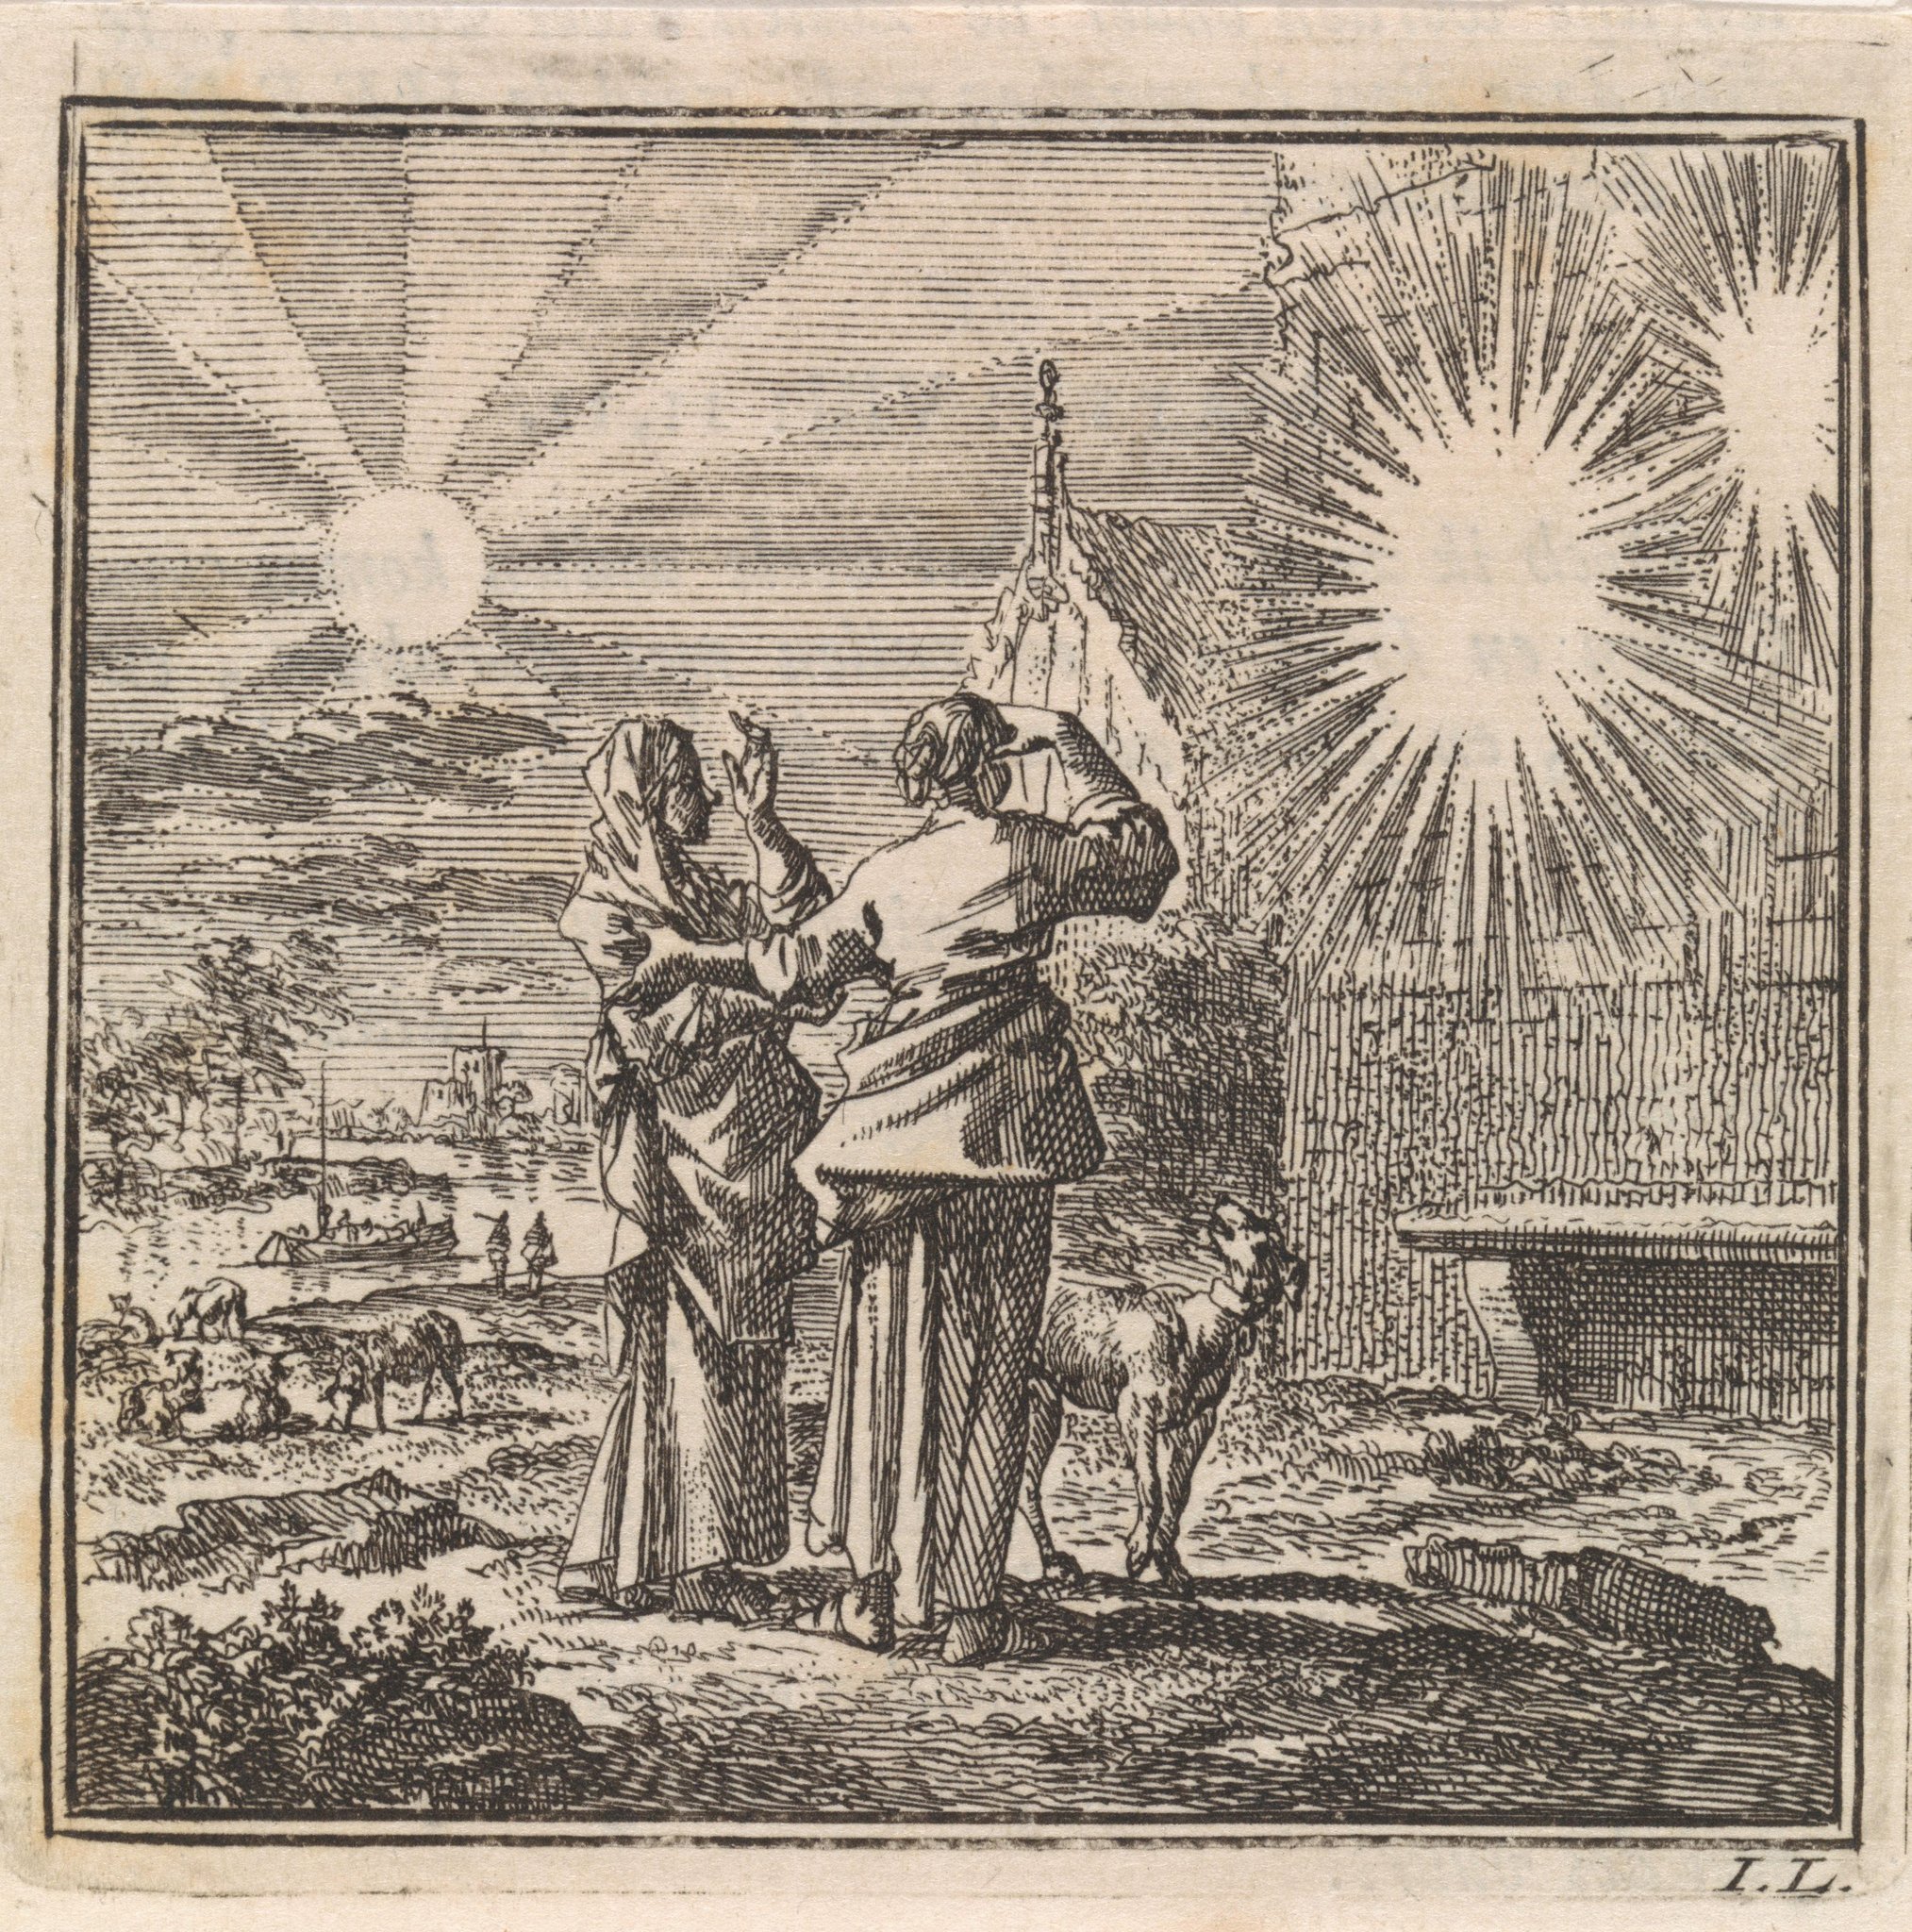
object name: book illustration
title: Twee vrouwen beschermen hun ogen tegen de reflectie van de zon op een venster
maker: jan luyken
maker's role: draughtsman, print maker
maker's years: 1649-1712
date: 1711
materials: paper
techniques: etching, letterpress printing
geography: amsterdam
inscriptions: collector's mark: Lugt 2228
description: Illustratie voor: Luyken, Jan. De Bykorf des Gemoeds. Amsterdam: Pieter Arentsz. II (wed.) en Cornelis van der Sys, 1711, p. 190.